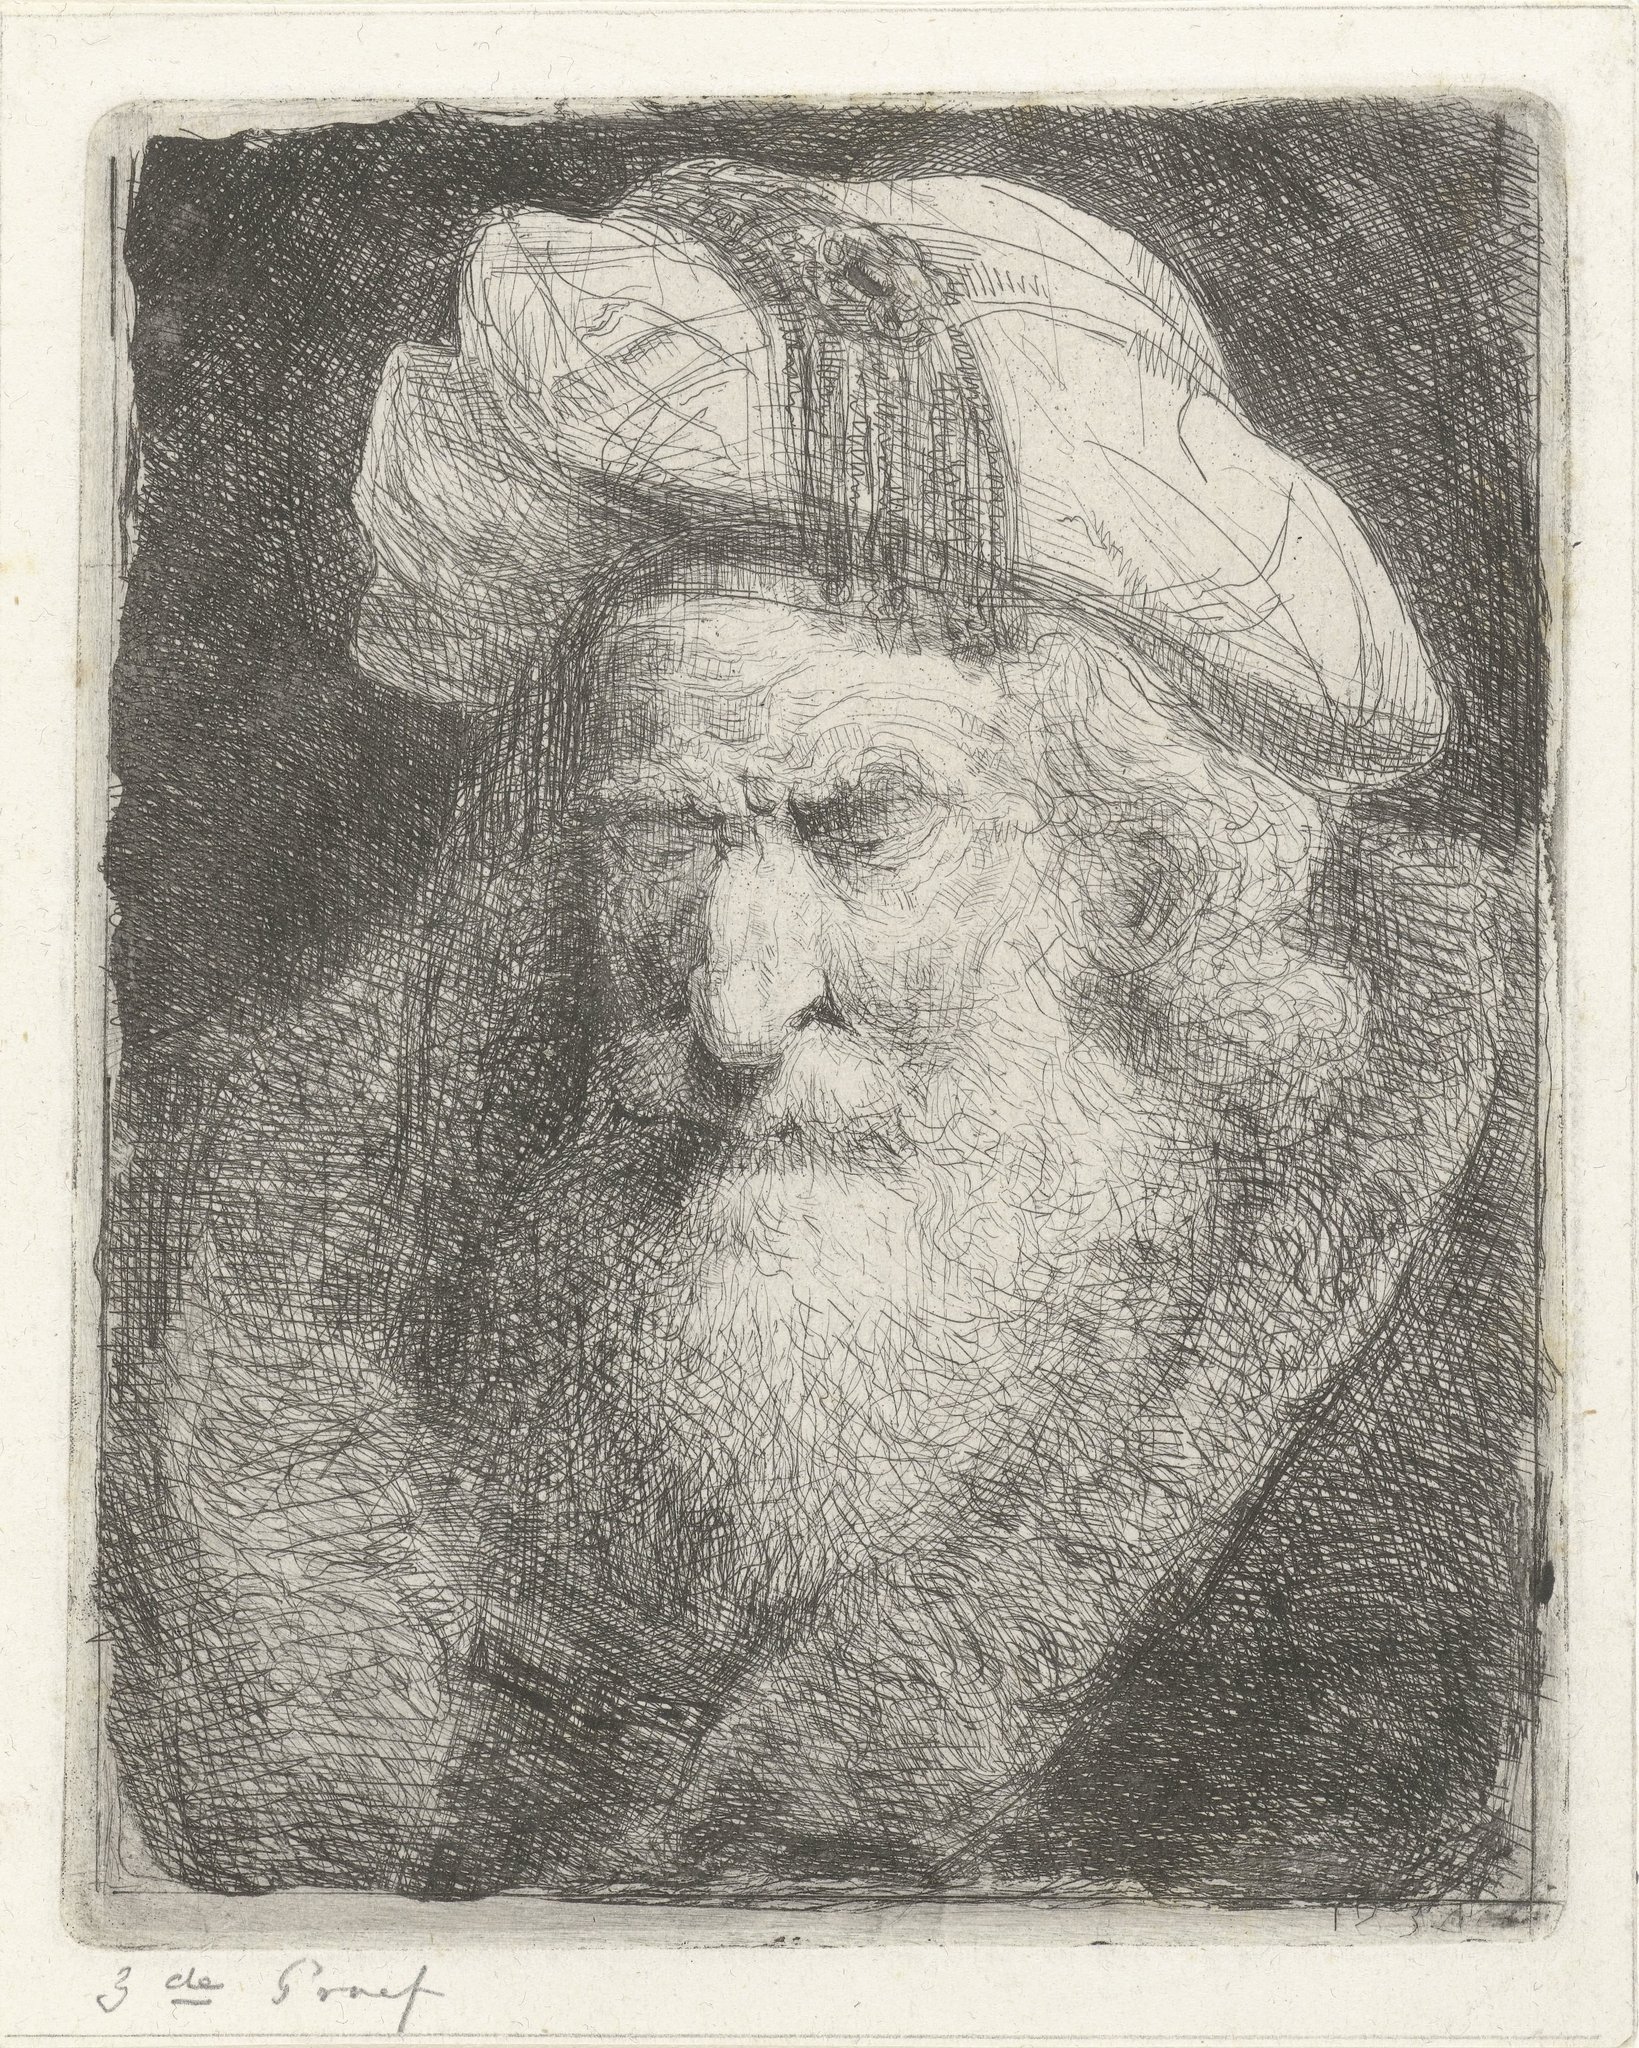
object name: print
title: Oude man met baard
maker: jacobus ludovicus cornet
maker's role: draughtsman, print maker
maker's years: 1815-1882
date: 1825-1882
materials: paper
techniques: etching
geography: leiden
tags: old man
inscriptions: collector's mark: Lugt 2228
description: Oude man met een baard en tulband. Buste naar links.